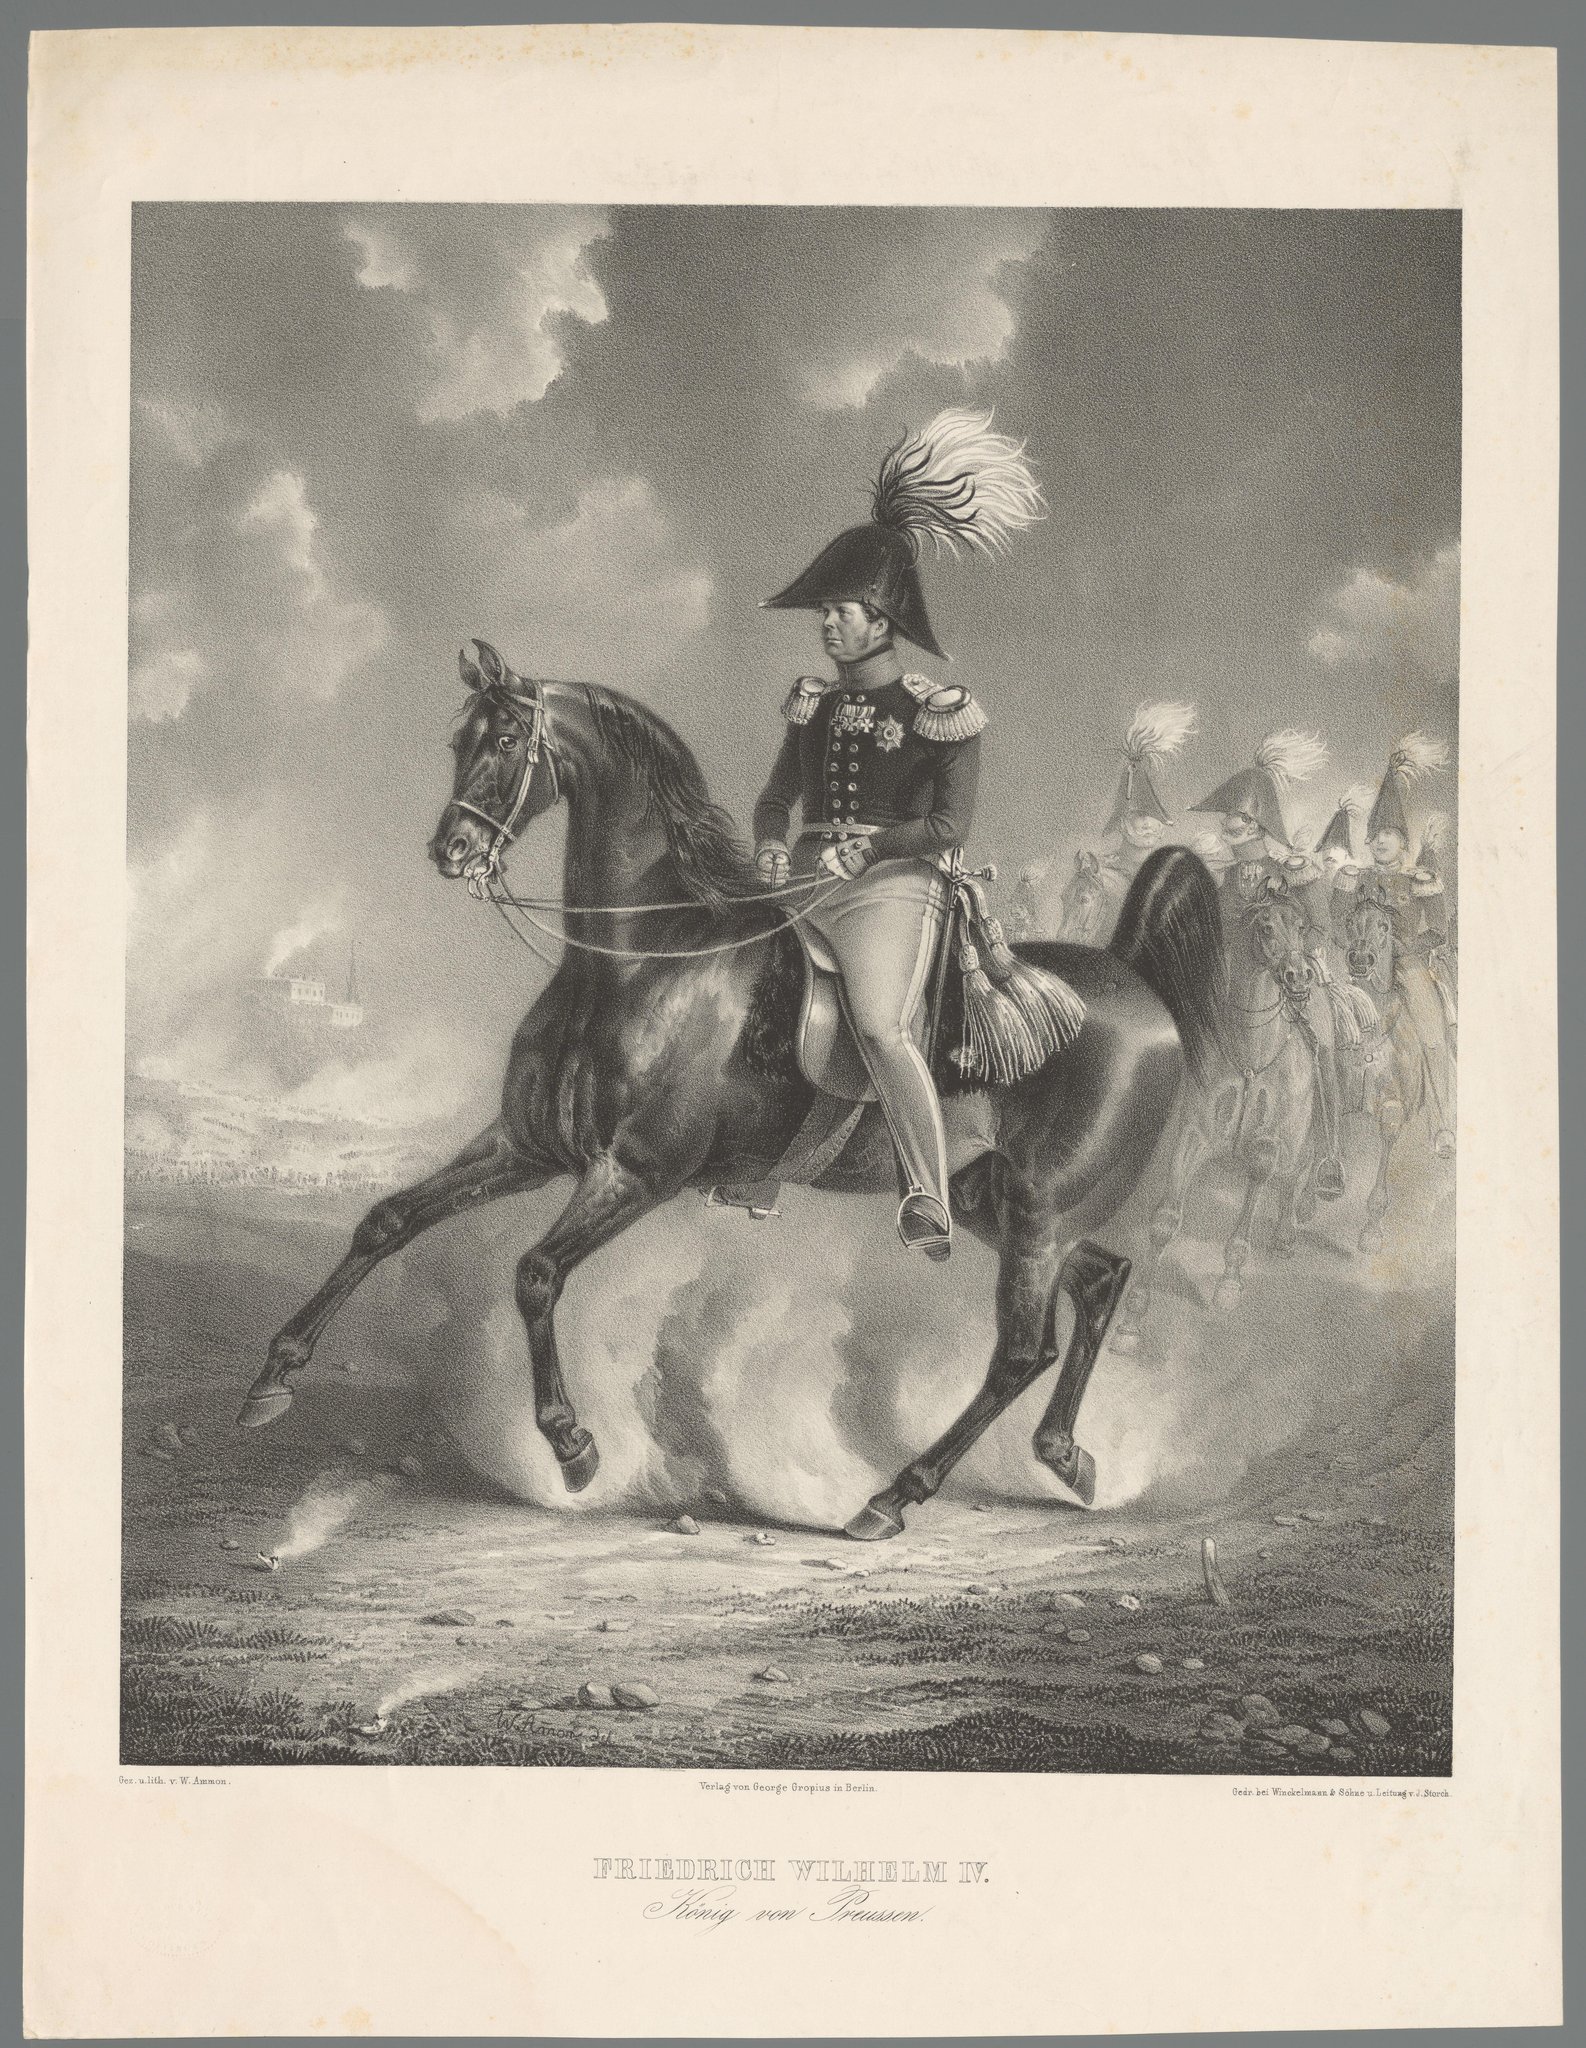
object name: print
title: Portret van Frederik Willem IV, koning van Pruisen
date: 1822-1895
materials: paper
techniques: lithograph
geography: berlin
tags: frederik willem iv (koning van pruisen), riding a horse, ass, or mule; rider, horseman, historical persons, king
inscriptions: collector's mark: Lugt 2228